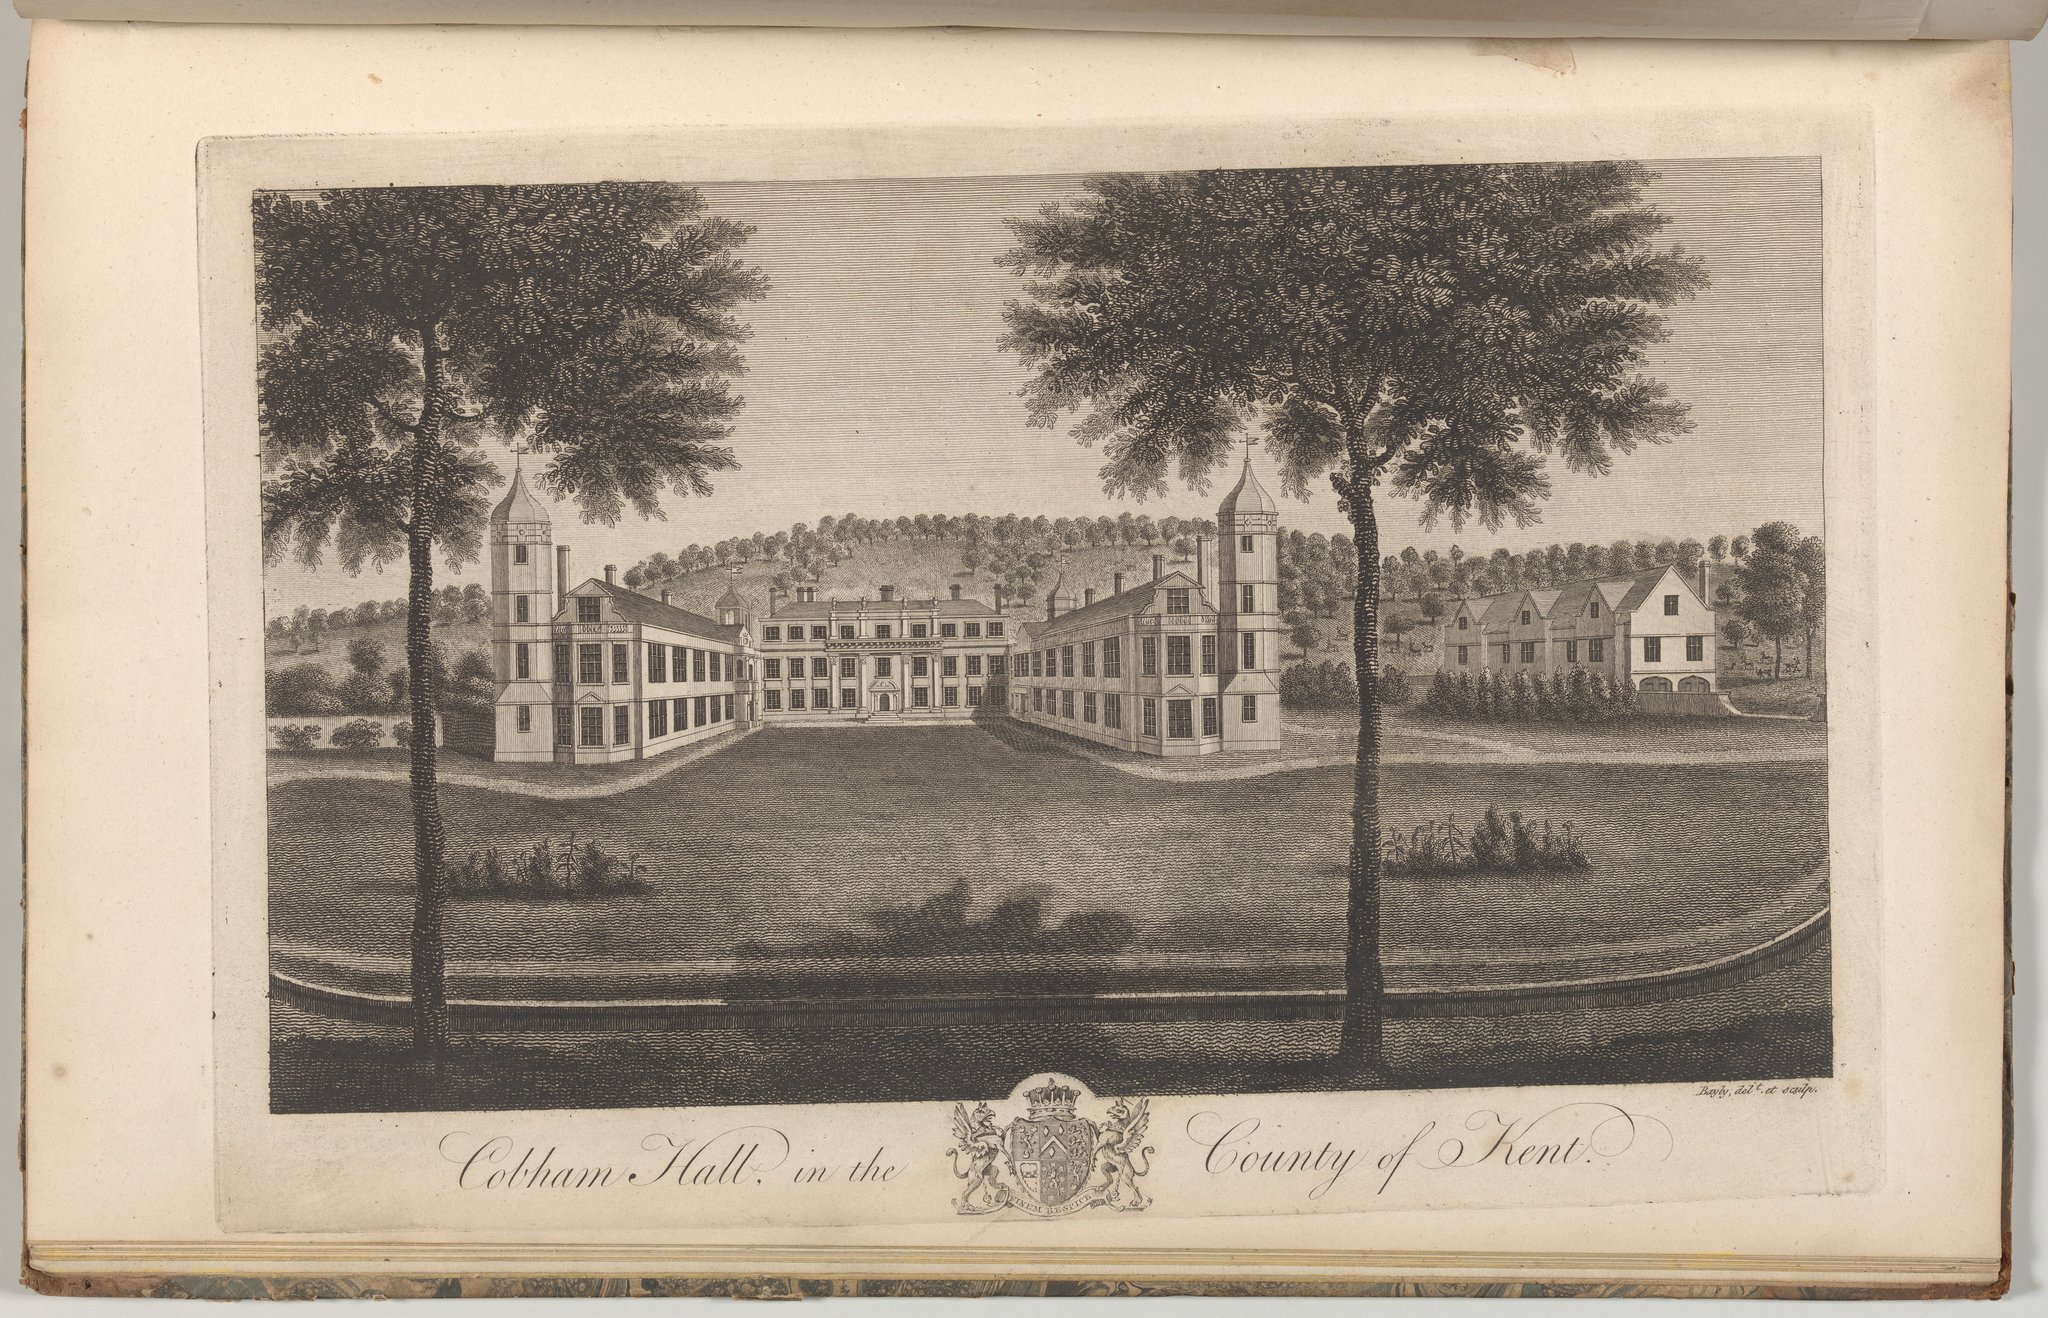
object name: print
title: Cobham Hall in the County of Kent, from Edward Hasted's "The History and Topographical Survey of the County of Kent", vols. 1-3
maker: john bayly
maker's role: artist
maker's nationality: british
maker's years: 1755-1782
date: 1777-1790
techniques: engraving, etching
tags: buildings,trees,coat of arms